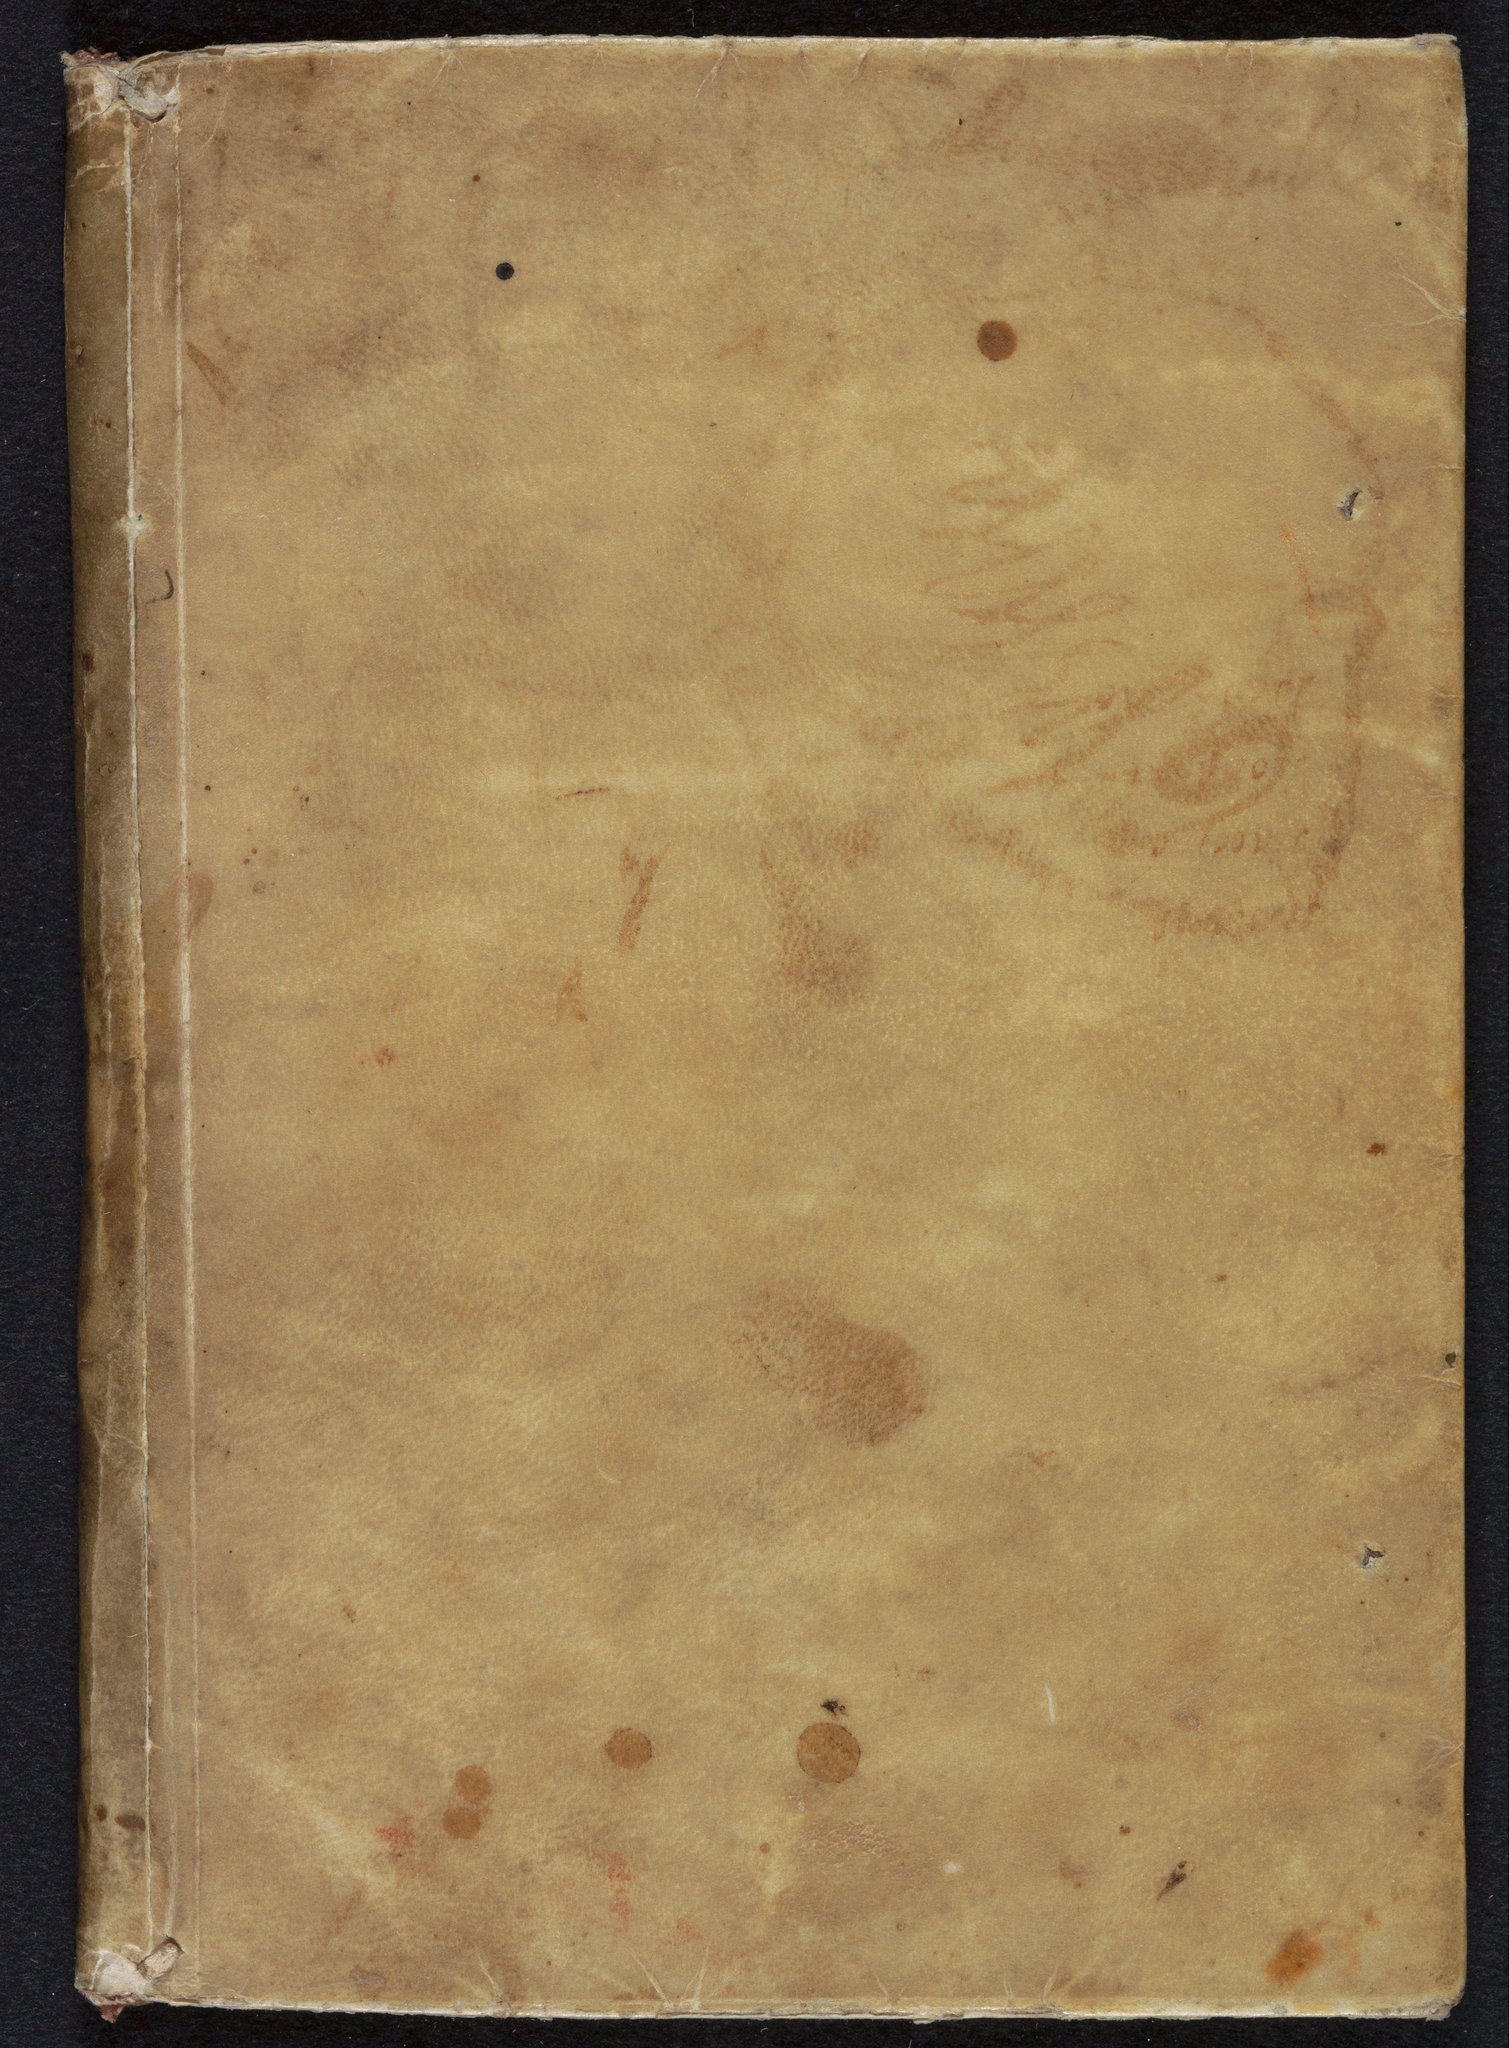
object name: prentrecueil, prentenalbum, prentalbum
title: Prentalbum met scenes uit het Nieuwe Testament in cartouches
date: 1570-1610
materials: ink, paper, parchment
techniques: bookbinding, engraving, metal cut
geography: antwerp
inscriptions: collector's mark: Lugt 2228, collector's mark: Lugt 2760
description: Vijftien gravures zijn gesigneerd met de monogrammen HSD, HDS of IS en bijna allemaal met het monogram PB. Het gaat om verschillende Zuid-Nederlandse prentmakers die naar Pieter van der Borcht hebben gewerkt. Bij het uitsnijden en inplakken van de gravures zijn vaak monogrammen en cijfers deels of geheel achter het papier onzichtbaar geworden of verdwenen. De cartouches zijn mogelijk Italiaans. 23 van de voorstellingen zijn gekopieerd naar een vergelijkbare reeks van Georg Pencz (ca. 1534-1535). De bijbelse scènes zijn mogelijk eerst in 1572 vervaardigd en uitgegeven (zie Dutch Hollstein, dl. XIII: Monogrammists of the 16th and 17th century). Het prentalbum is hoogstwaarschijnlijk aan het eind van de 16de of het begin van de 17de eeuw in Italië samengesteld voor devotionele doeleinden en ingebonden in een perkamenten band.